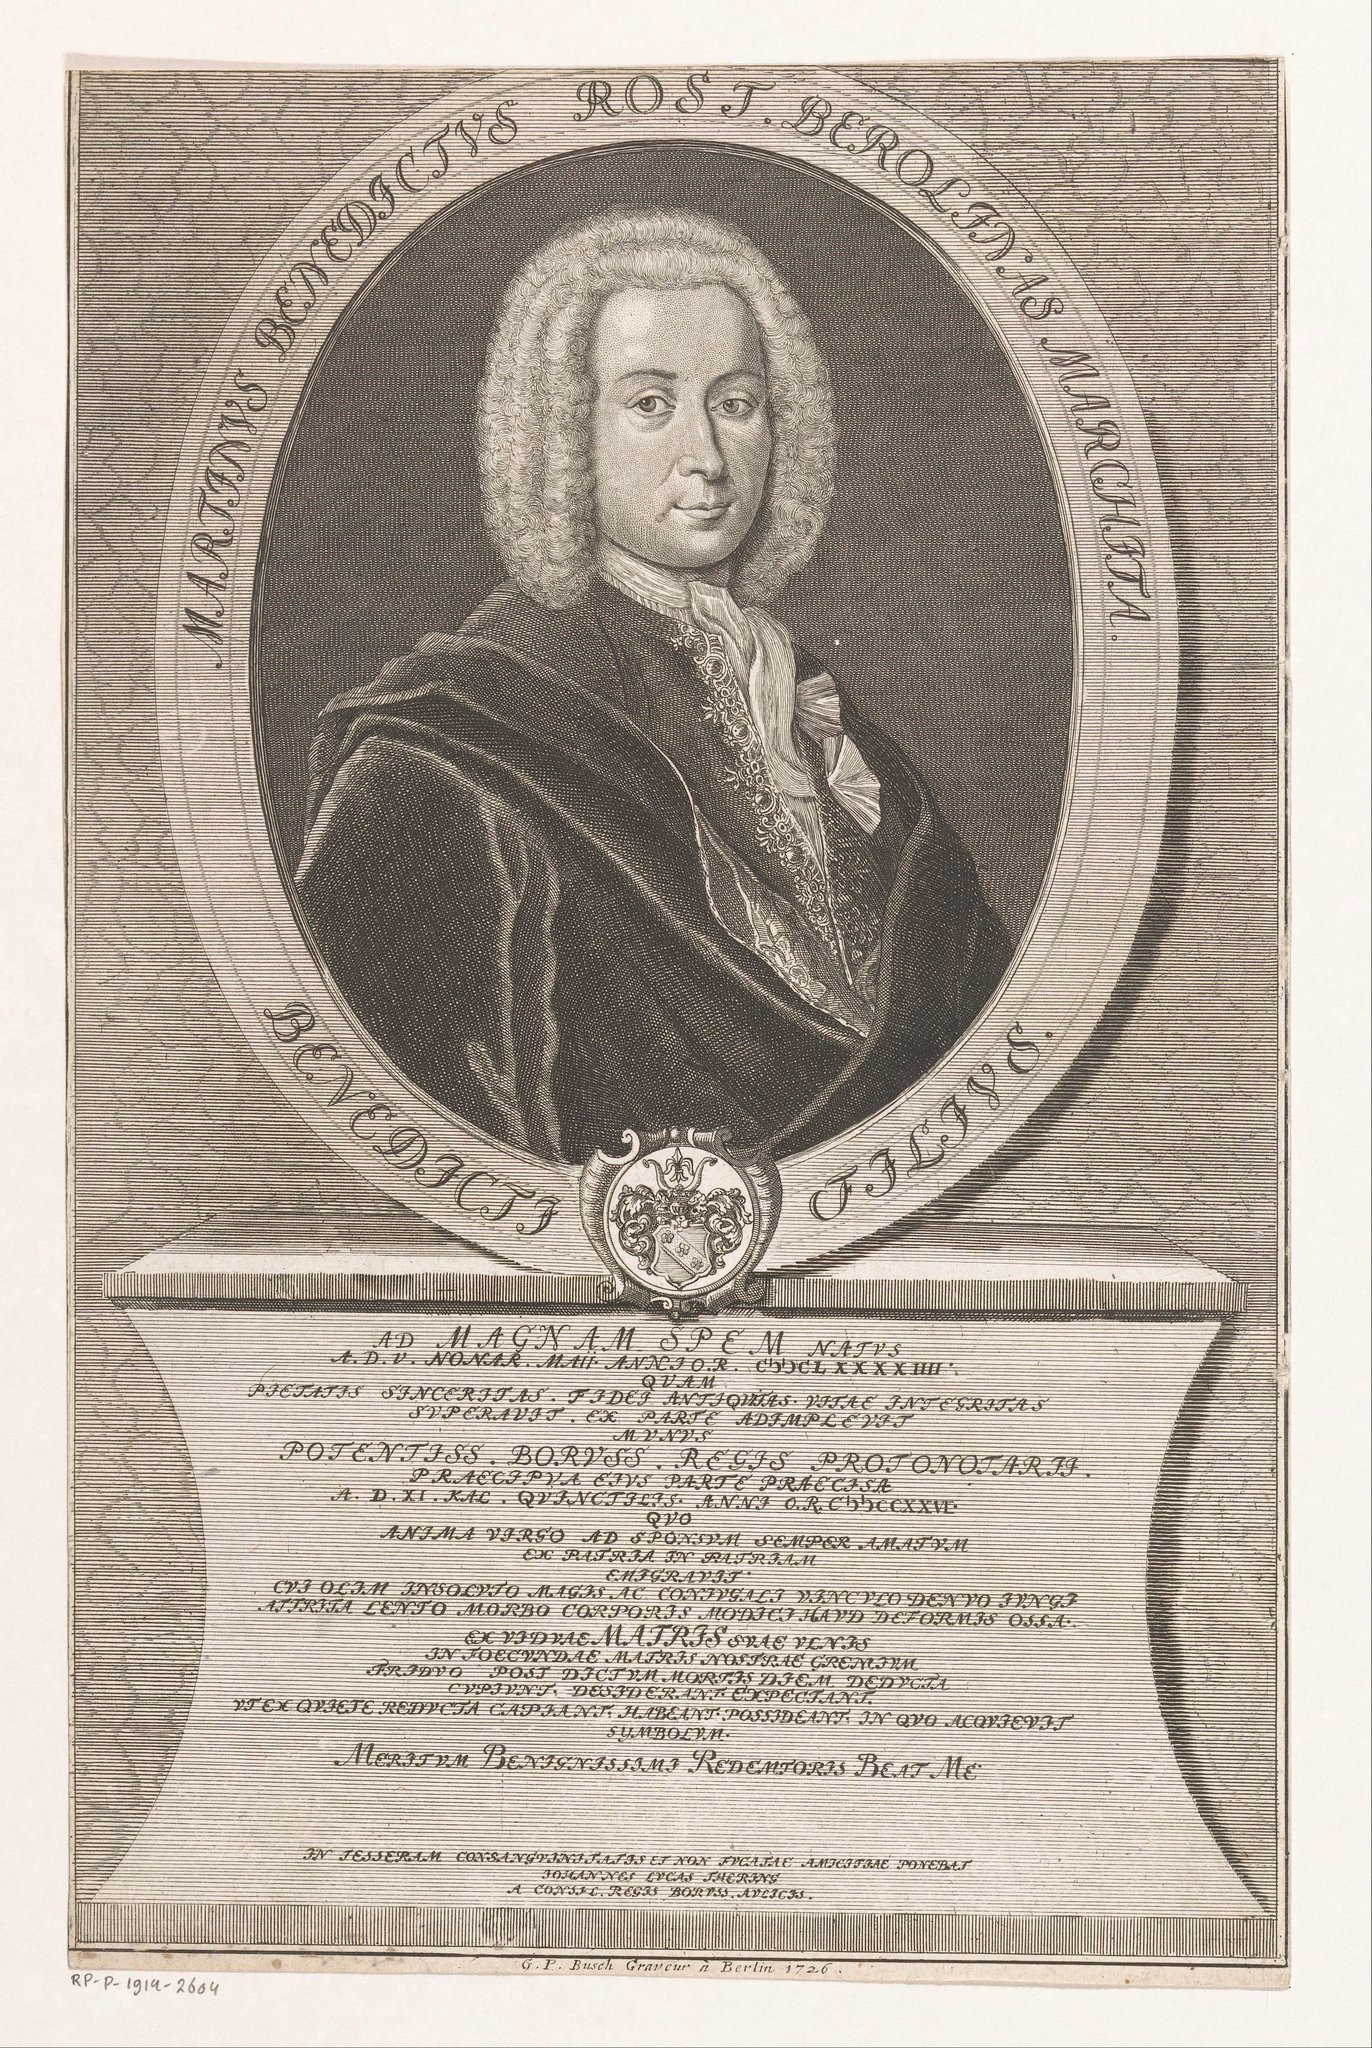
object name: print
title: Portret van Martin Benedict Rost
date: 1726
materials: paper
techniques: engraving, etching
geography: berlin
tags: martin benedict rost, historical persons, armorial bearing, heraldry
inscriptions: collector's mark: Lugt 2228